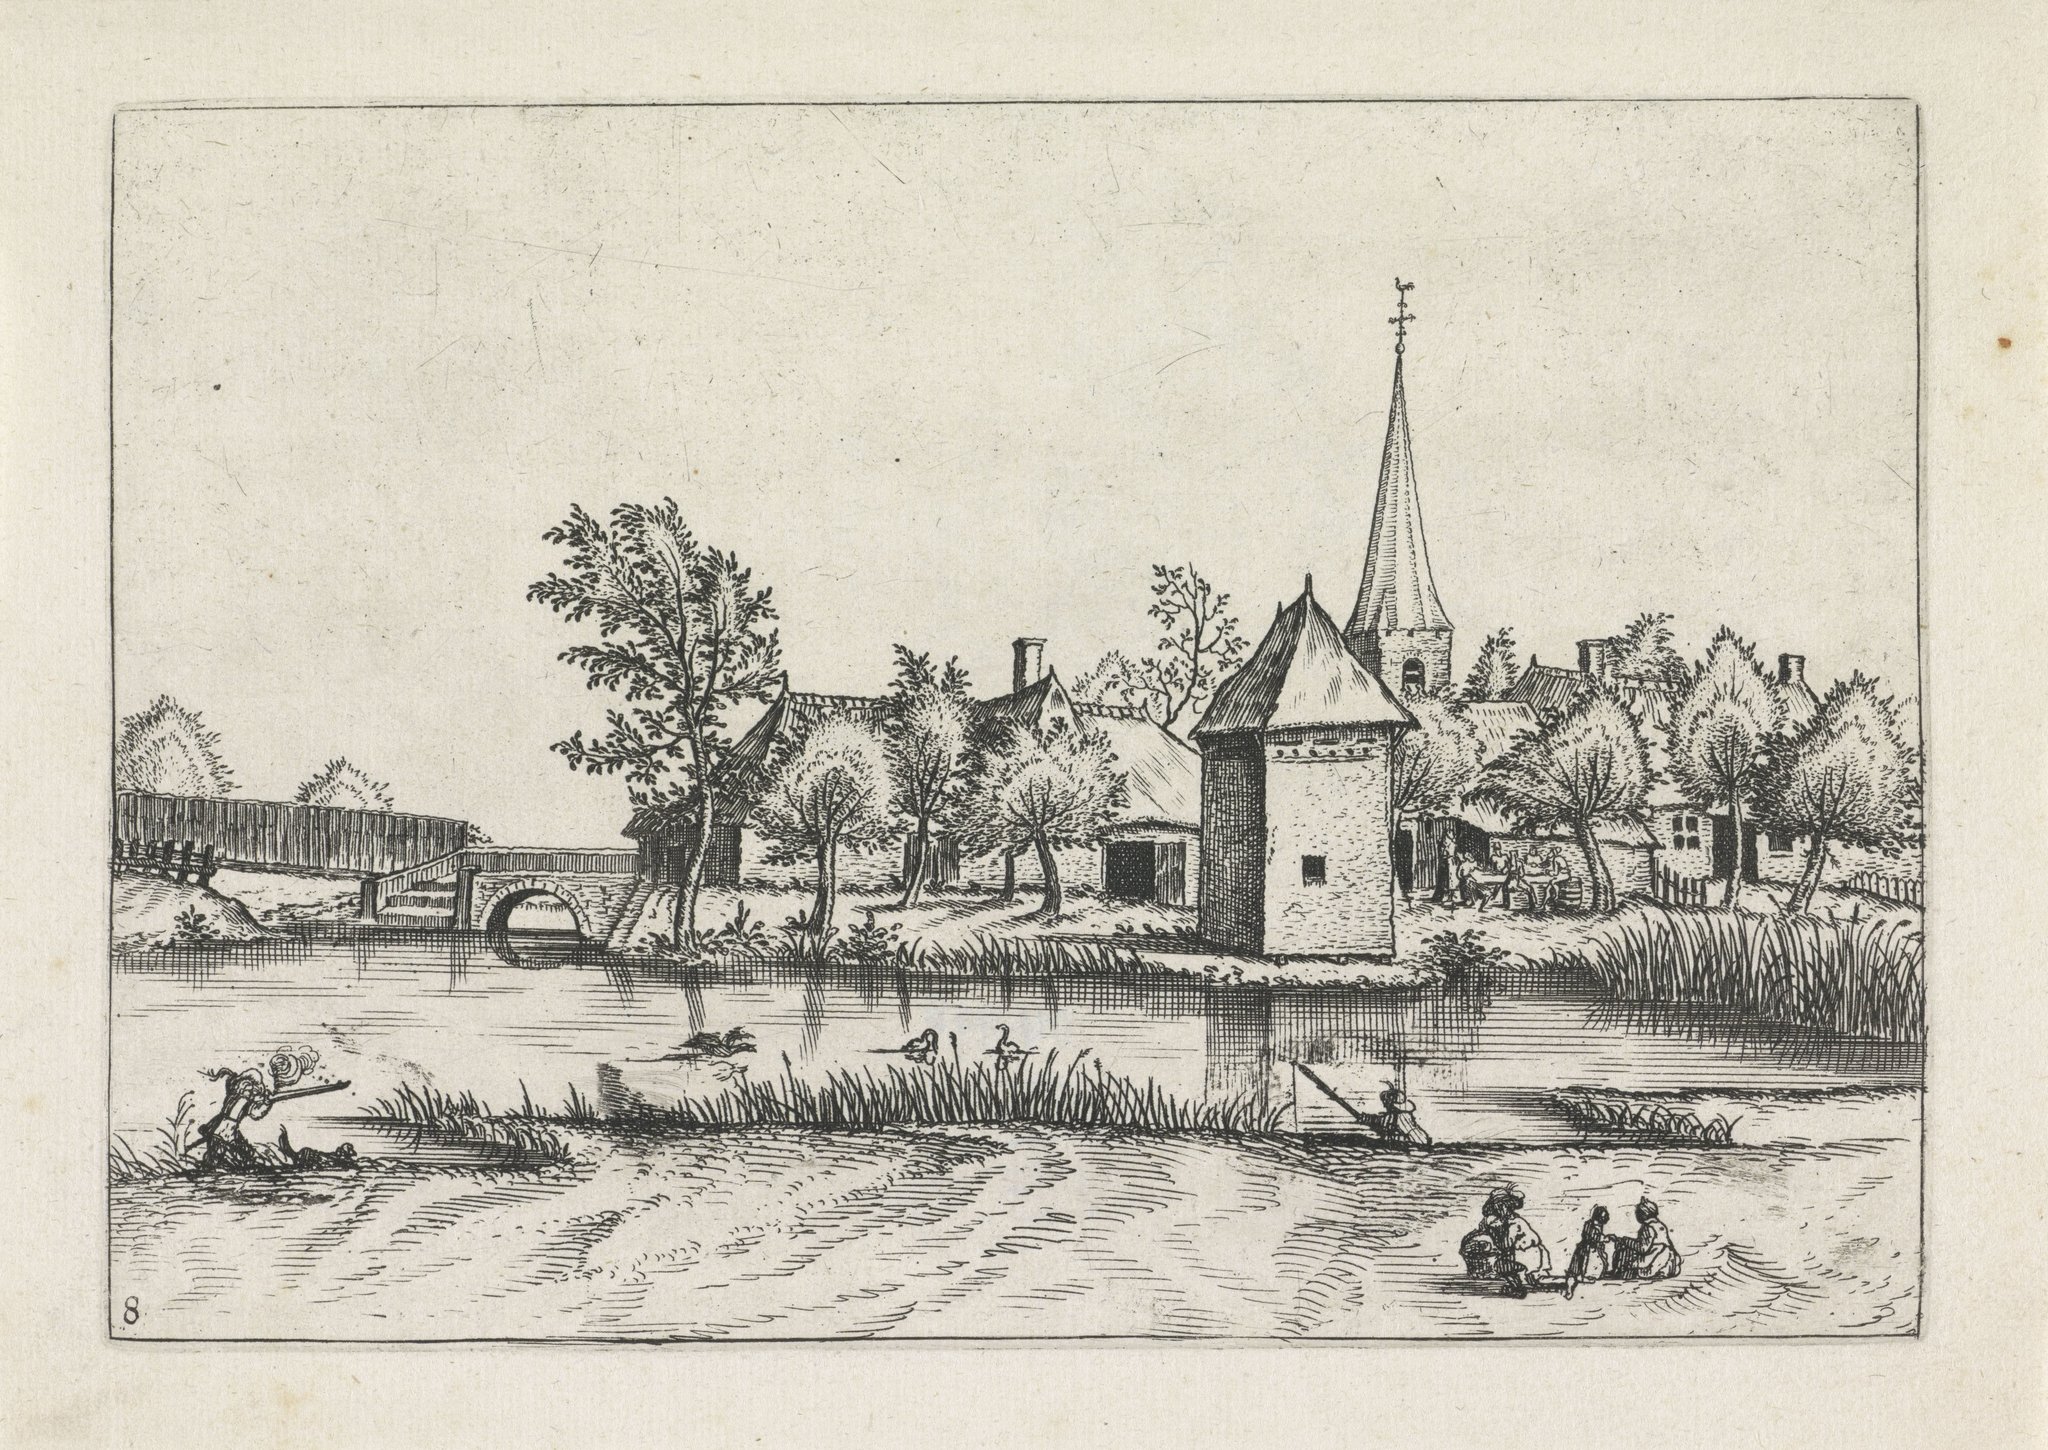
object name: print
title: Gezicht op een dorp met brug en een kerk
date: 1559-1561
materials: paper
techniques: etching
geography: antwerp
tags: village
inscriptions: collector's mark: Lugt 2228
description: Gezicht op een dorp met kerktoren, aan de andere zijde van het water gelegen. Links een brug over het water.